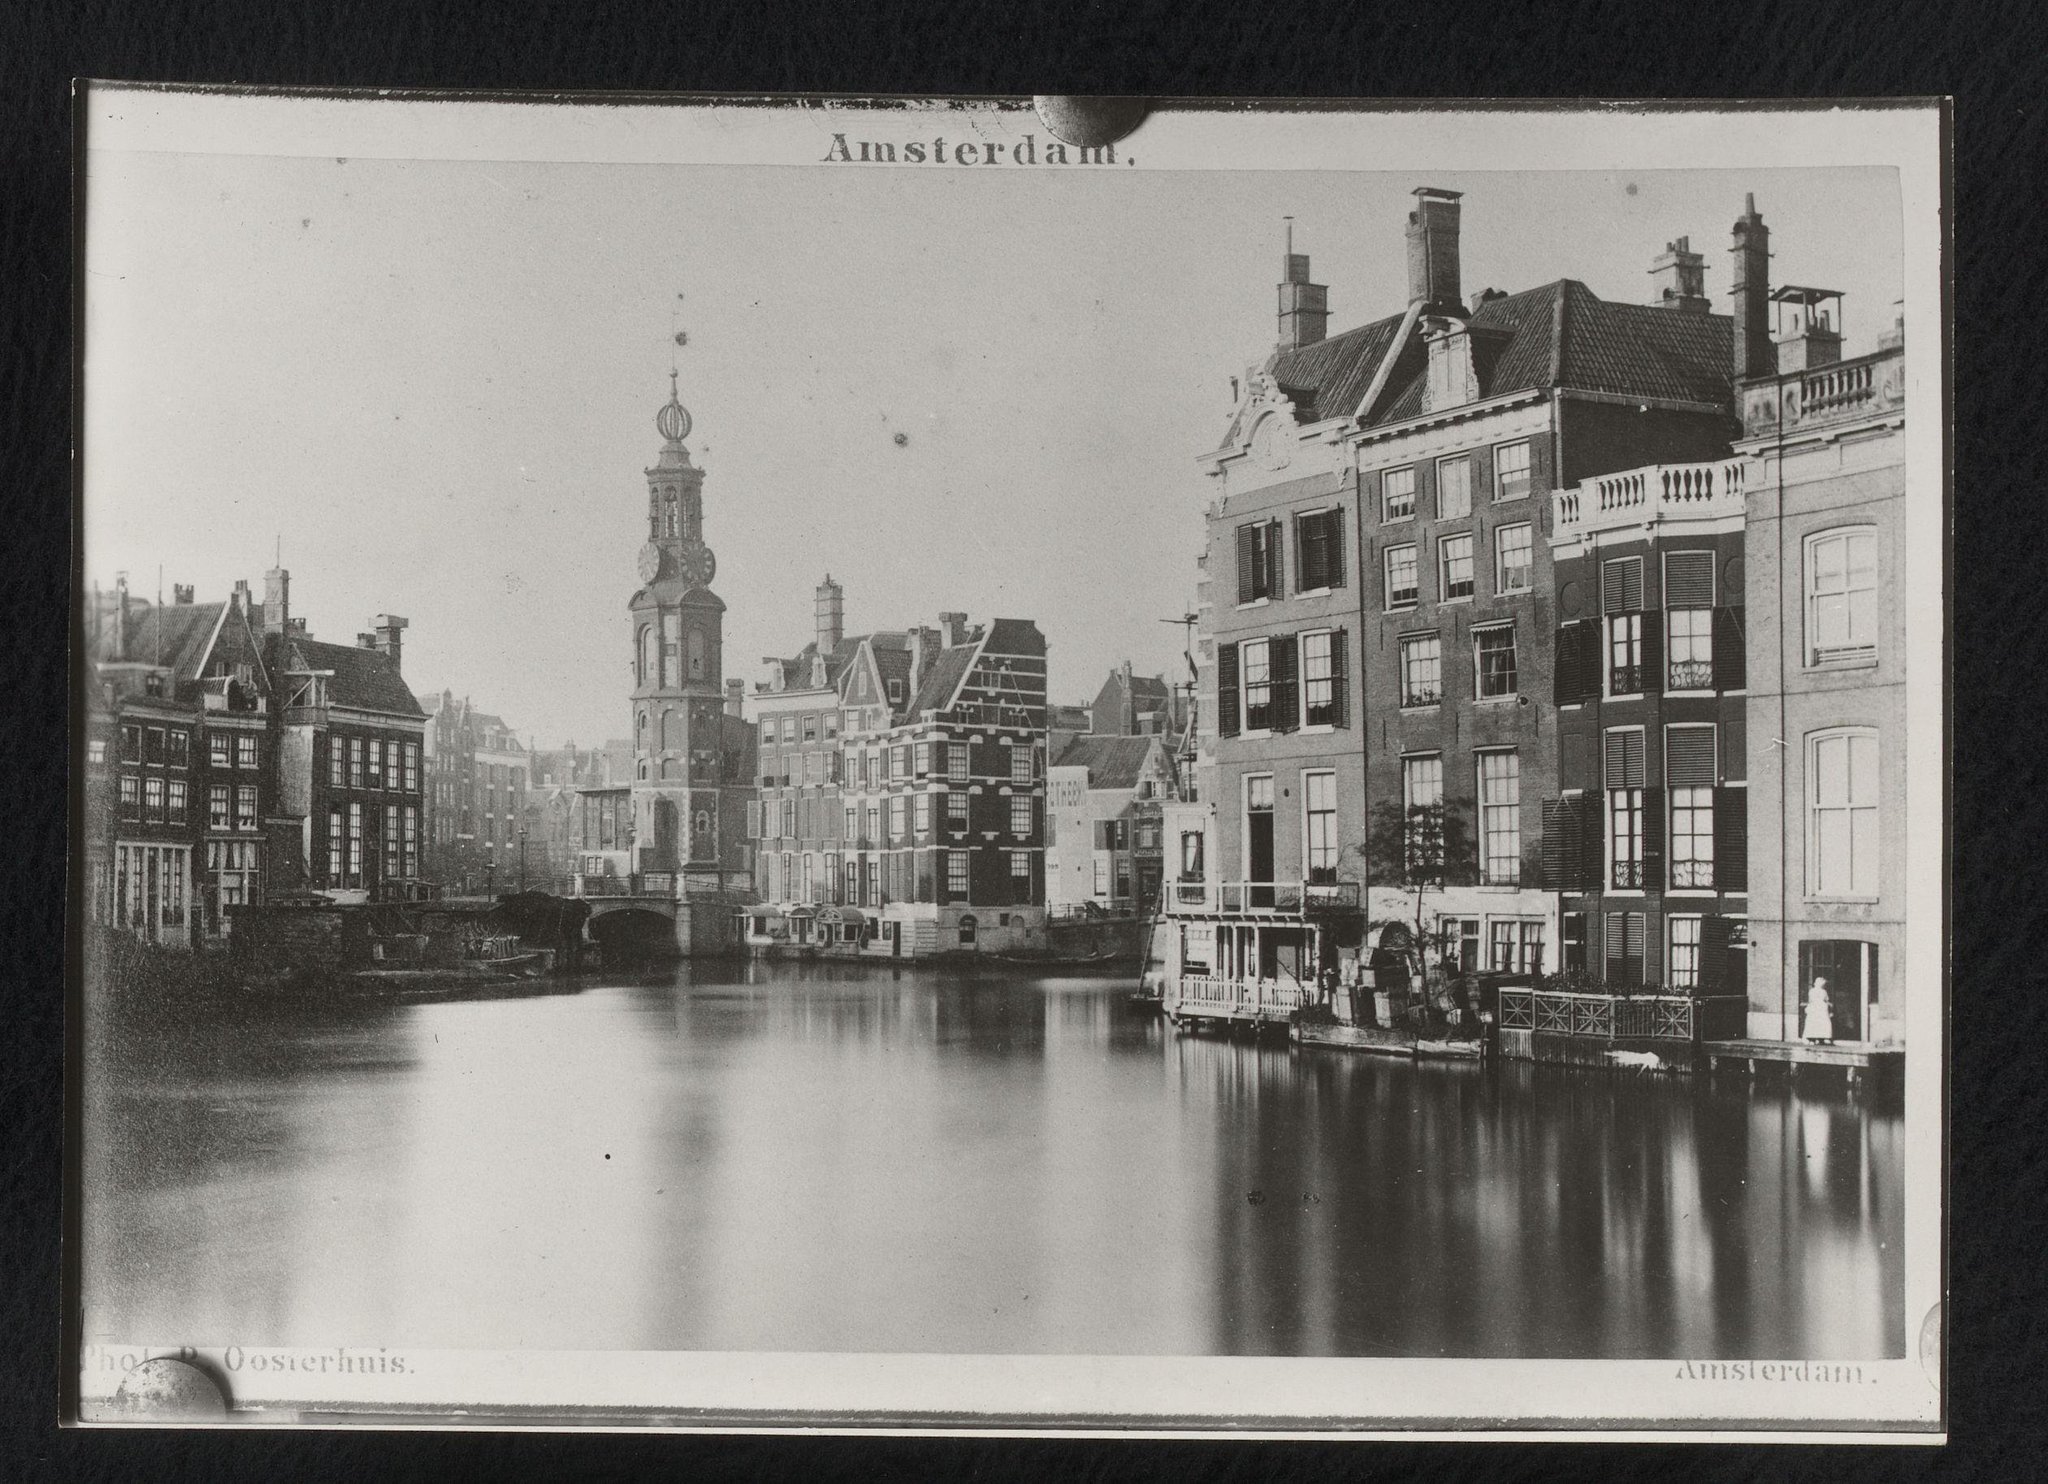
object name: photograph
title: Amsterdam vóór 1882 gezicht op de achterzije der huizen a.d. N. Doelenstraat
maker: Anonymous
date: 1930-1931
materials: paper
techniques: gelatin silver print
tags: urban housing, canals, waters (in city)